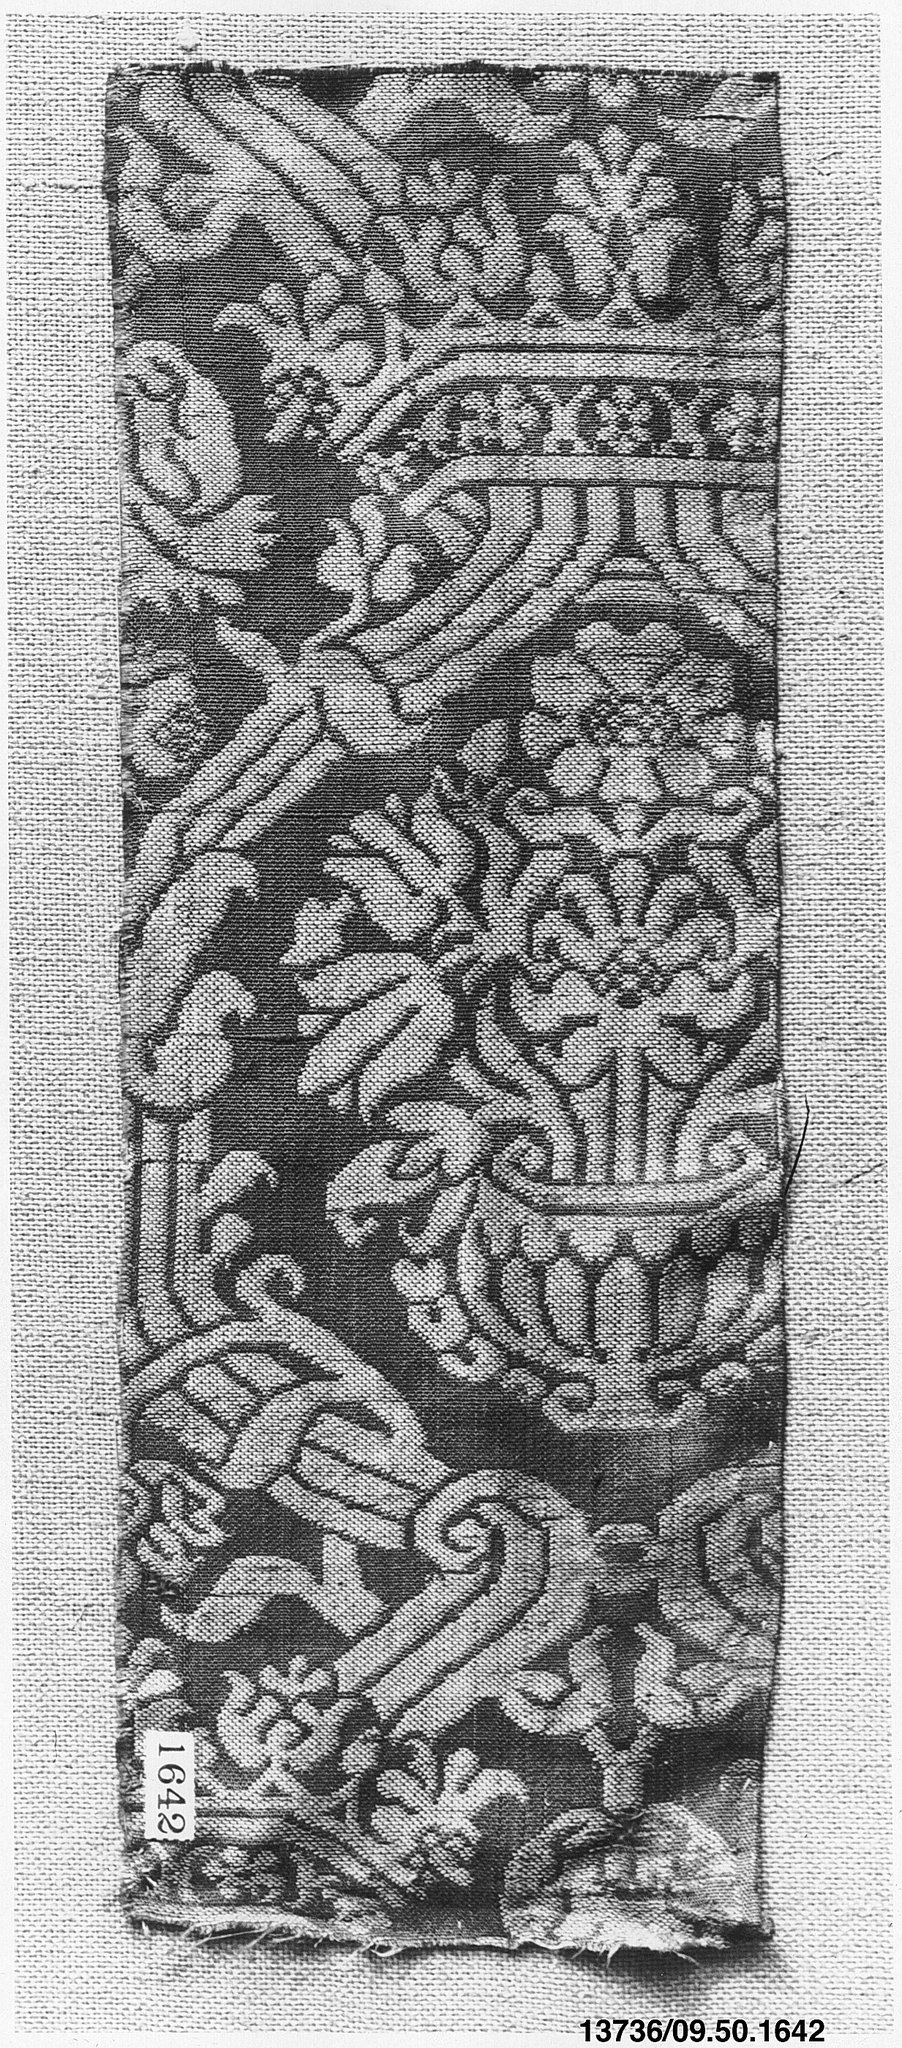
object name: piece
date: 1501-1600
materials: silk